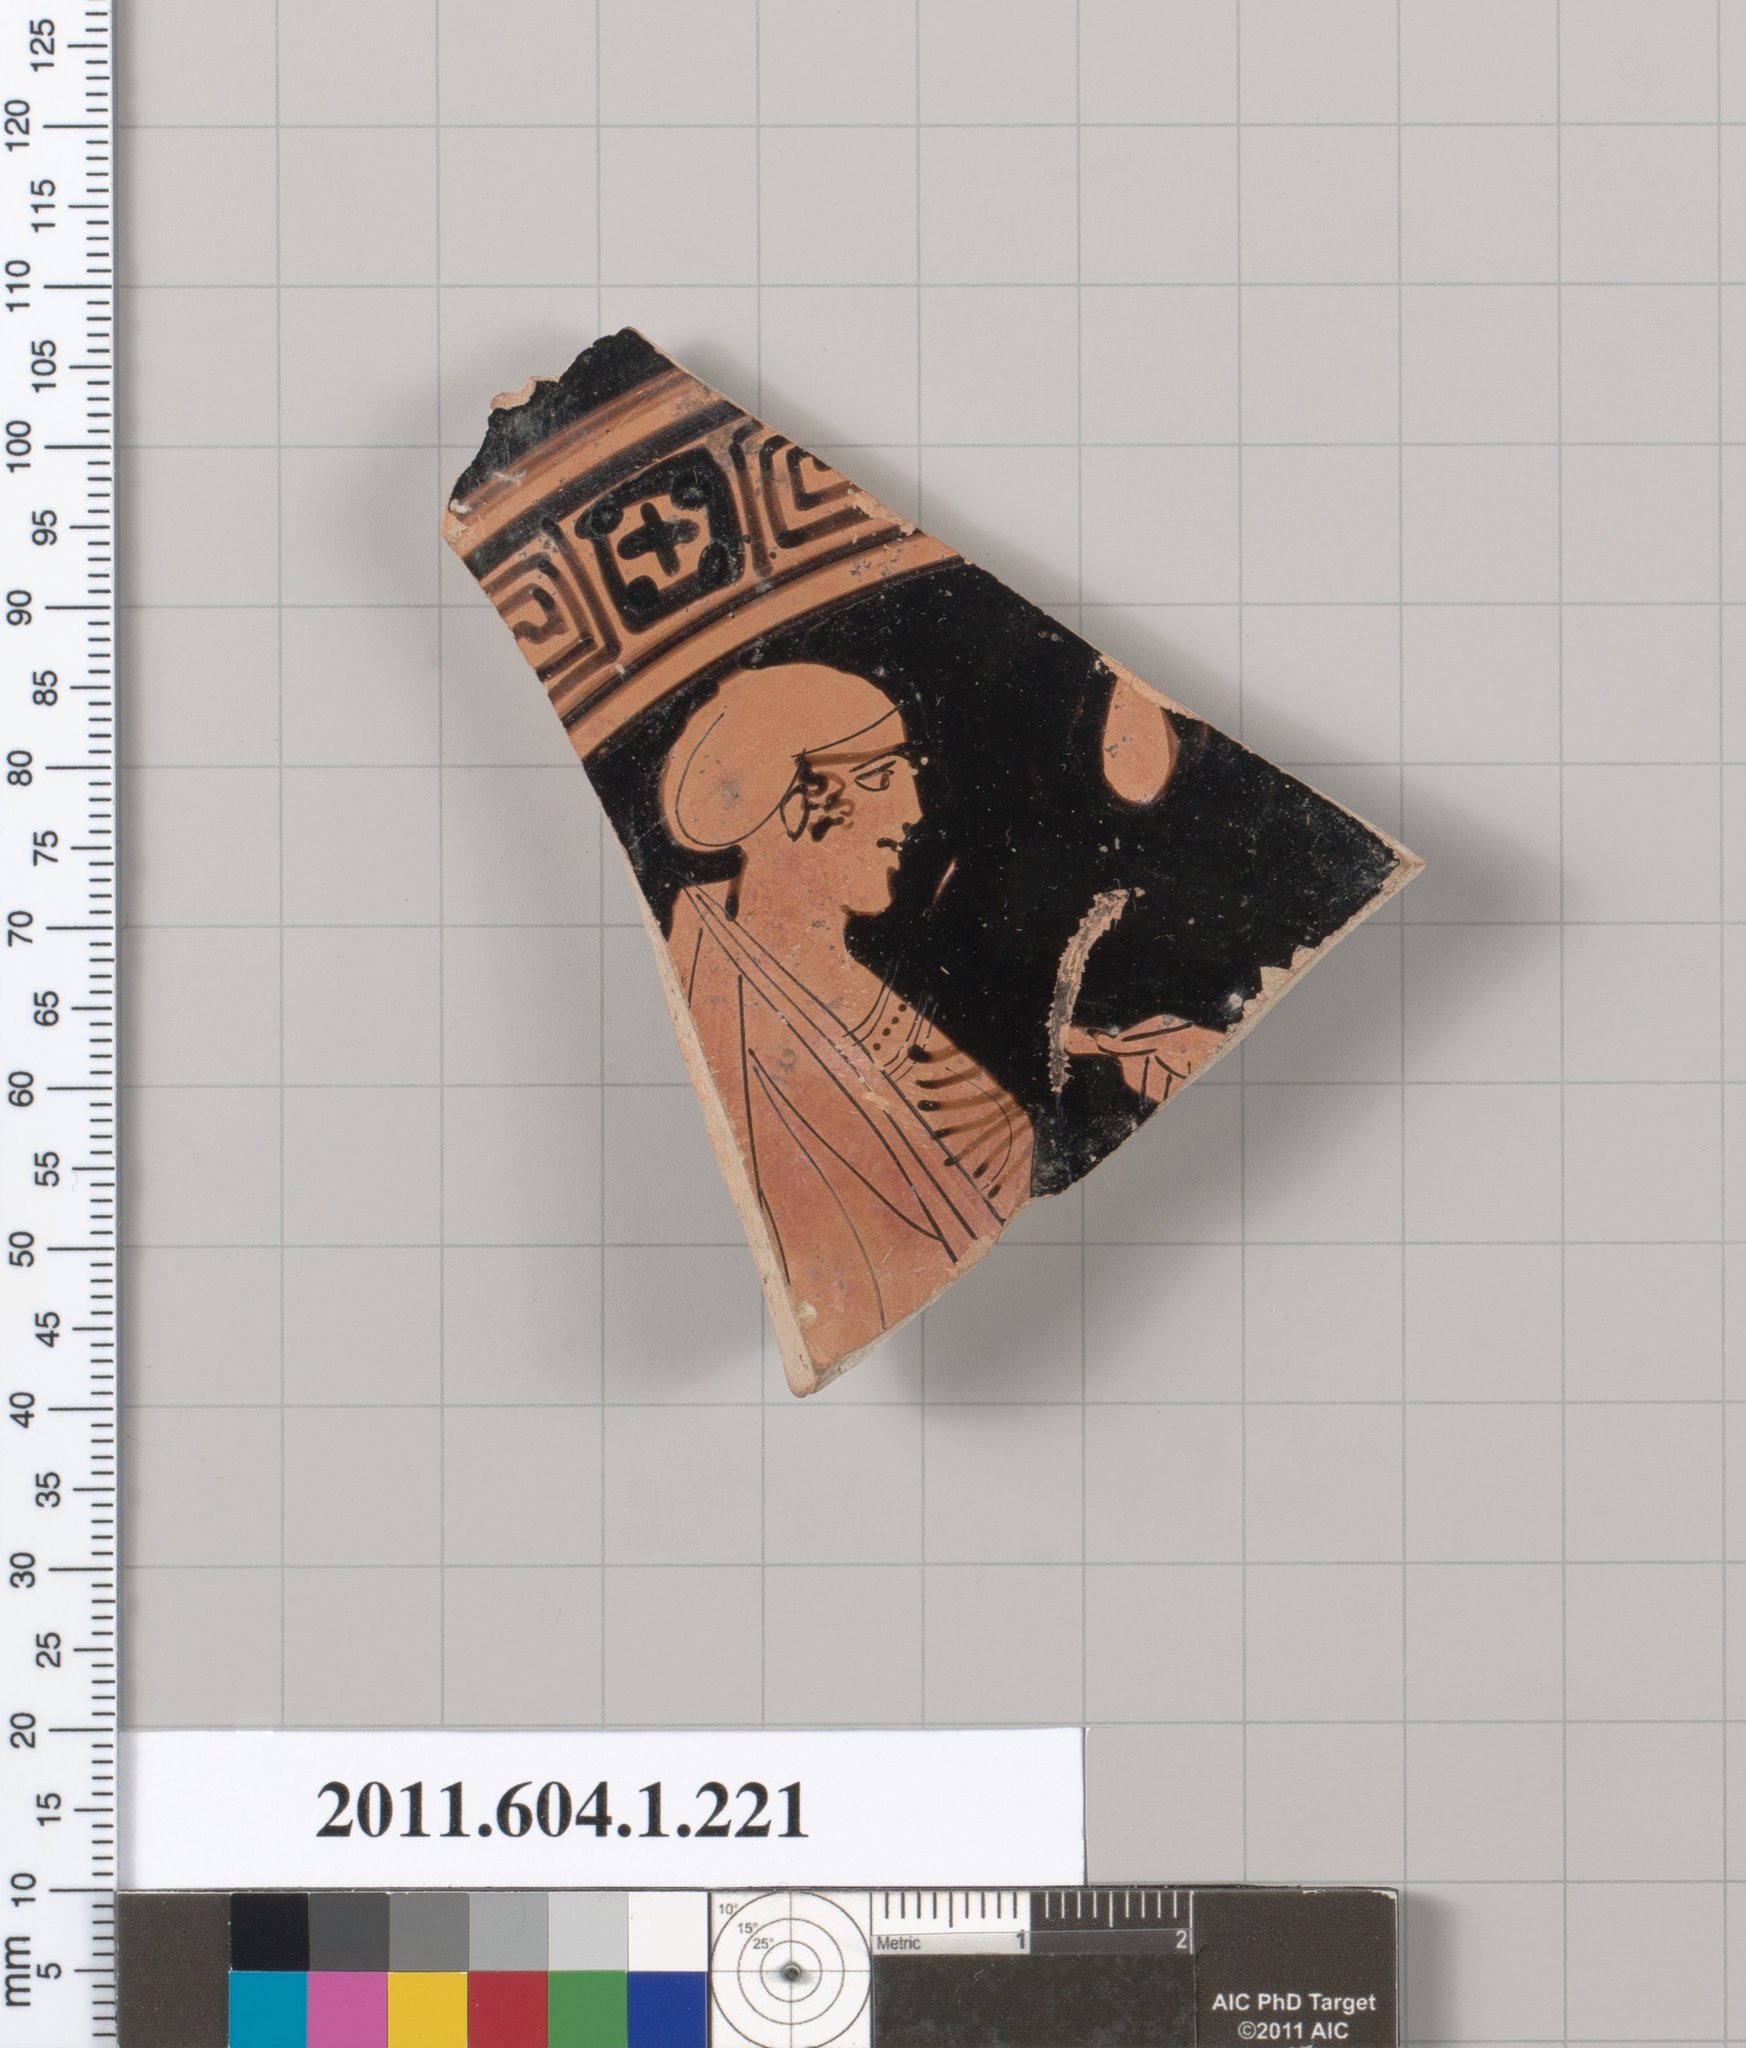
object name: kylix fragment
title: Terracotta fragment of a kylix (drinking cup)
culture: greek, attic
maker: painter of brussels r 330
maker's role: artist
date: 475-451 BCE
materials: terracotta